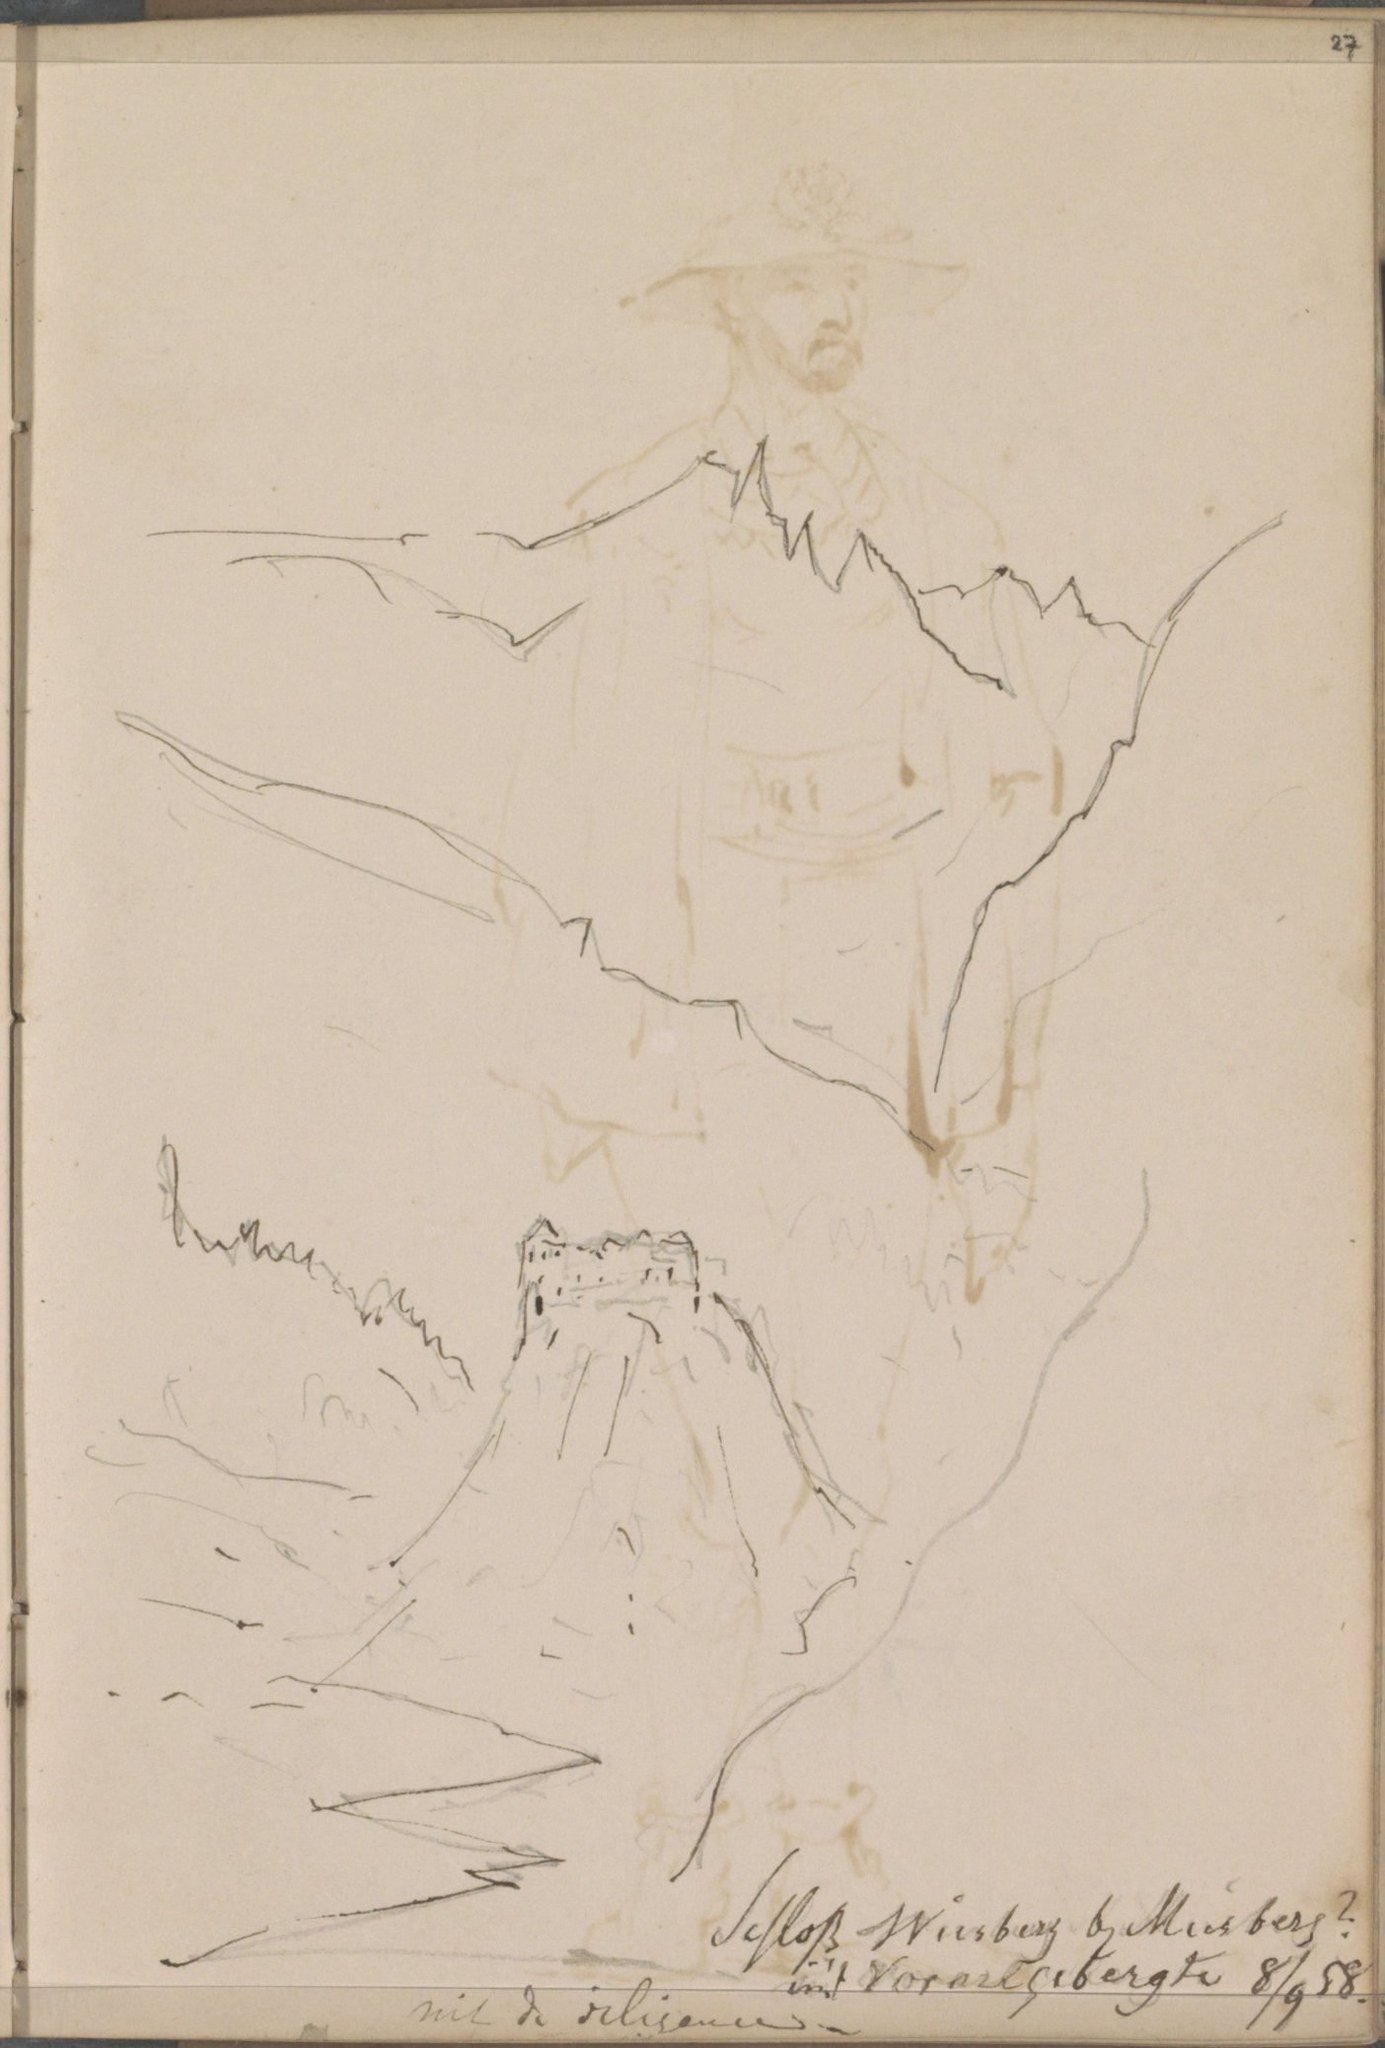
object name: sketchbook leaf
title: Slot Wiesberg in het Voralgebergte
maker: johannes tavenraat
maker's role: draughtsman, painter, print maker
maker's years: 1809-1881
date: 1809-1858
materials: ink, paper, pencil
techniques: pen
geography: austria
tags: landscape with tower or castle, mountain-range, snow peaks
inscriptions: date and inscription: ‘Schloss Wiesberg bij Me[..]berg?/ in 't Voralgebergte 8/9 58./ uit [...]’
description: Blad 27 recto uit een schetsboek met 47 bladen.